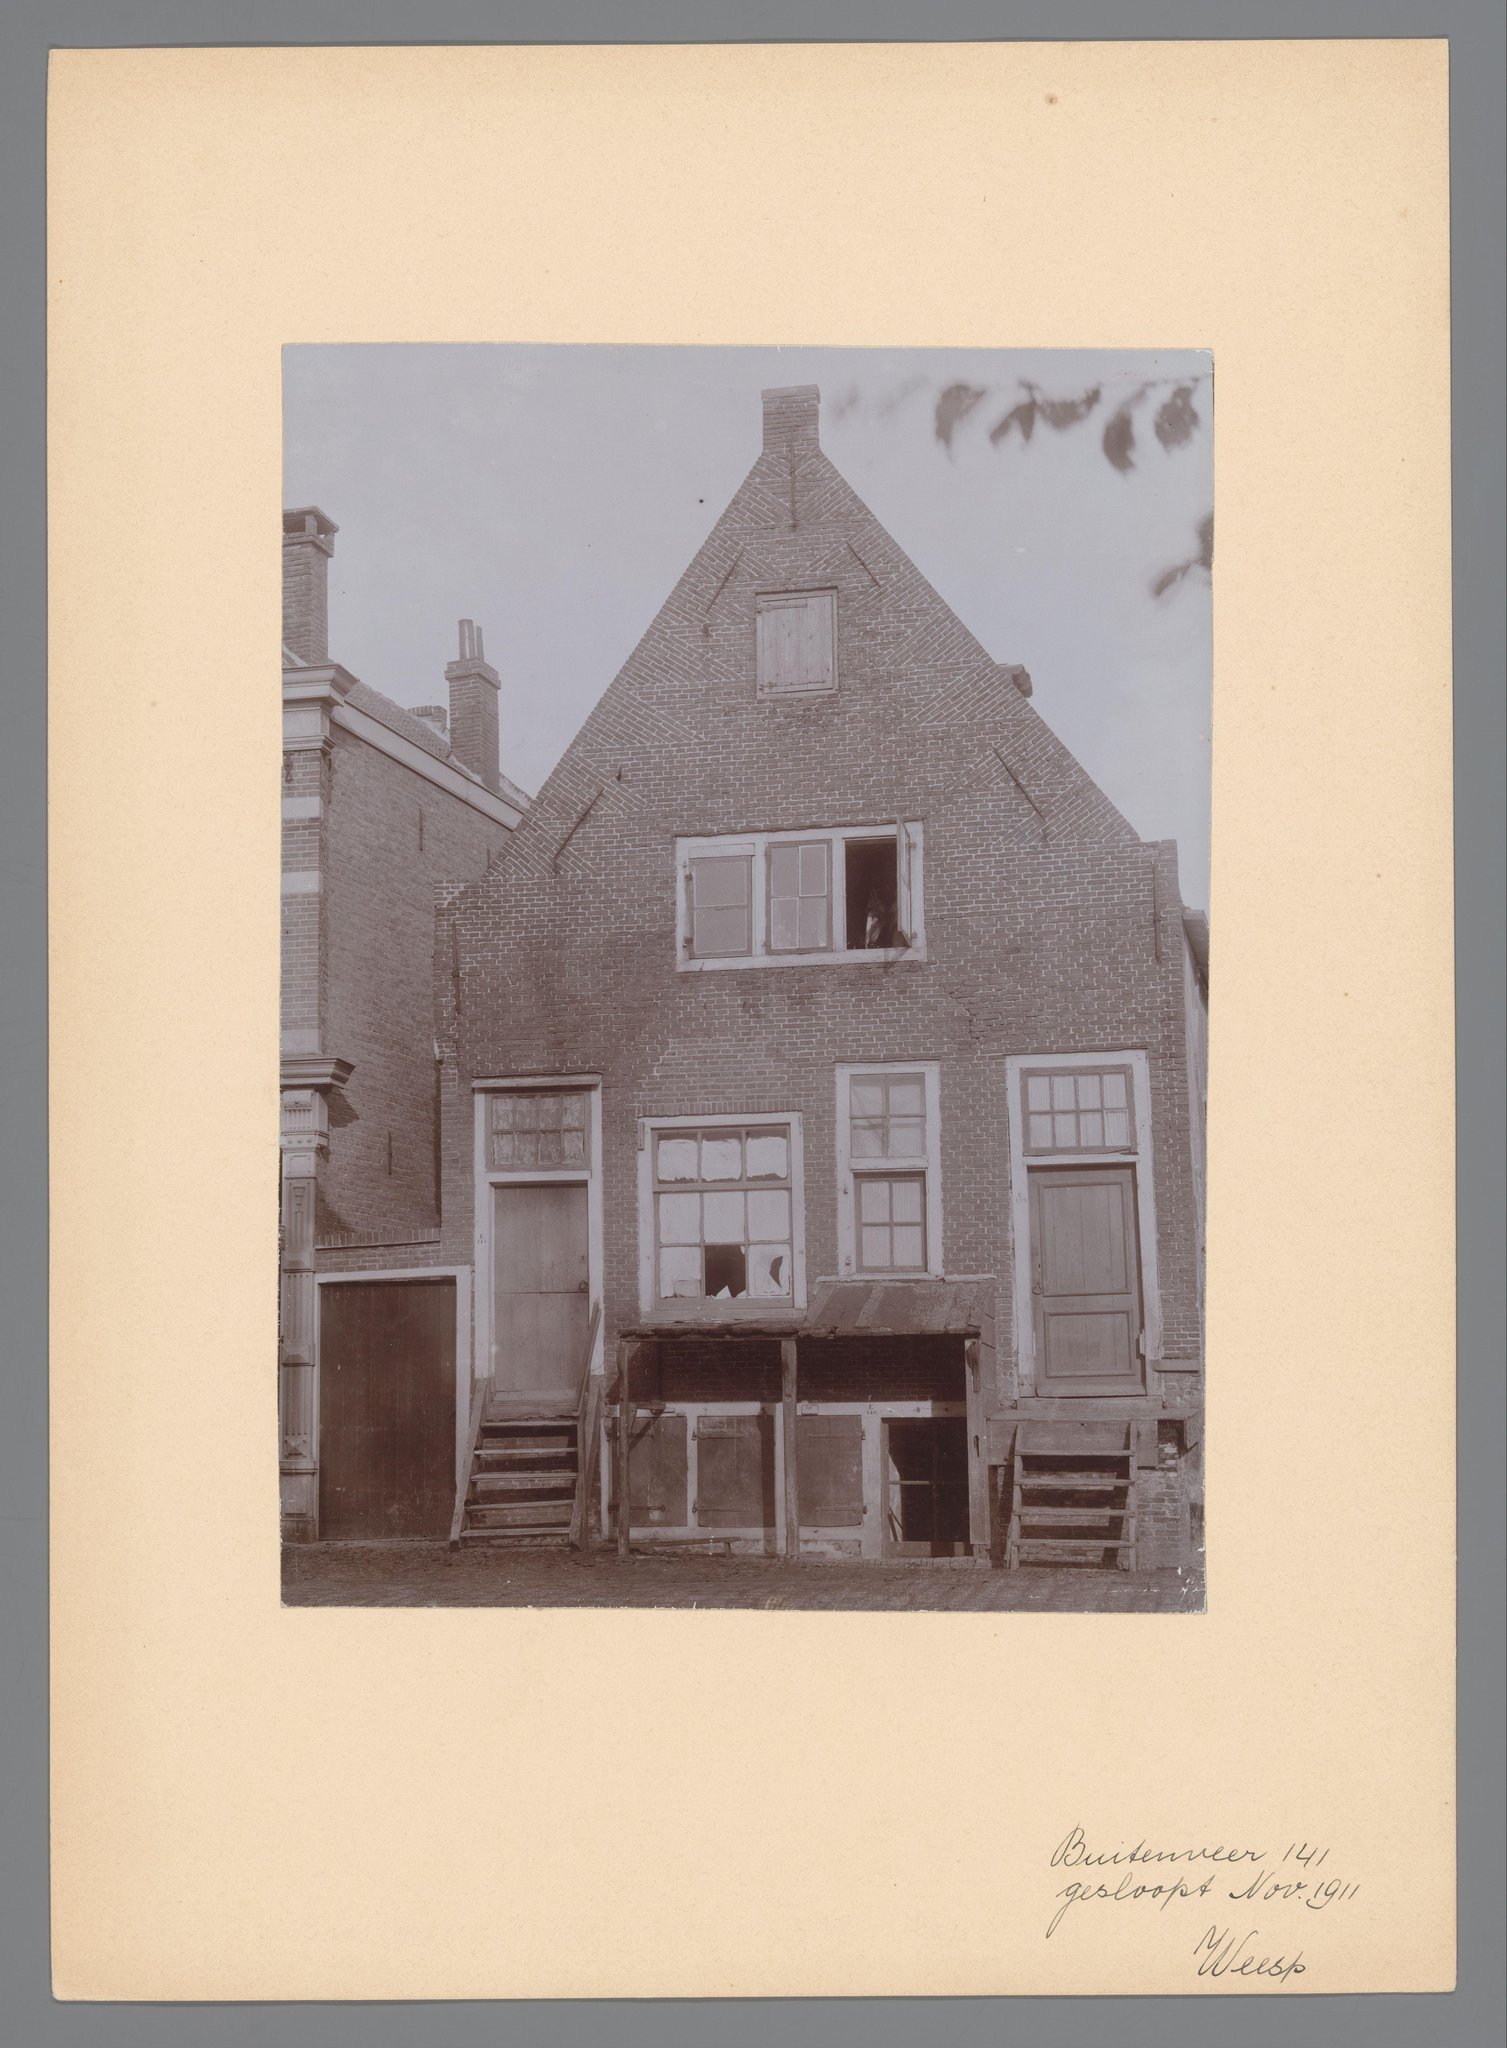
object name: photograph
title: Façade van Buitenveer 141 te Weesp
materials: cardboard, photographic support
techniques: collodion silver print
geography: weesp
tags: urban housing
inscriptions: annotation: ‘Buitenveer 141/ gesloopt nov. 1911/ Weesp’